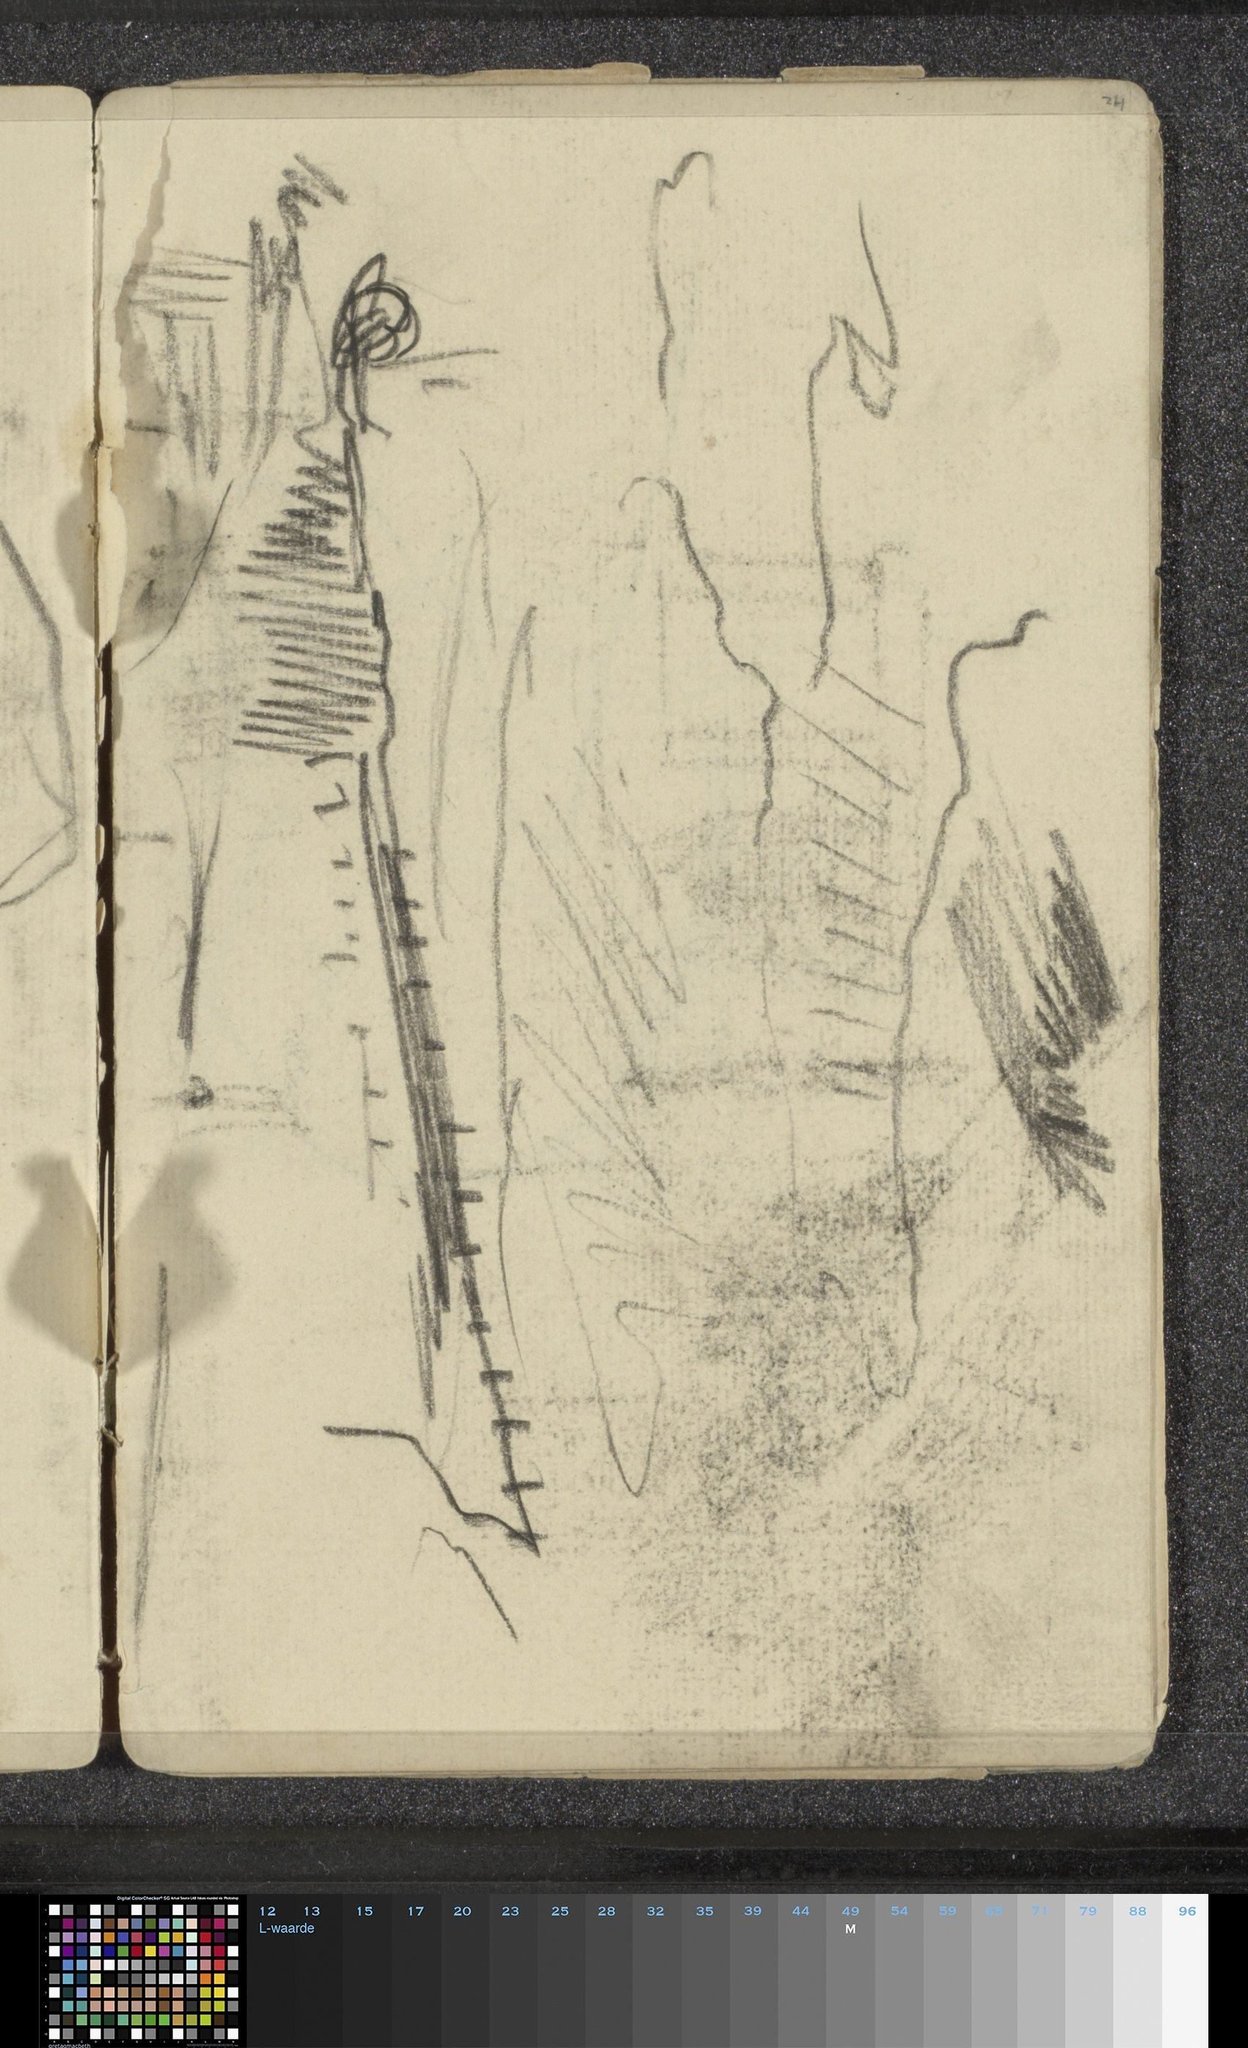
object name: sketchbook leaf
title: Studie, mogelijk van een boot in een landschap met wolkenlucht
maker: george hendrik breitner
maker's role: draughtsman, painter, print maker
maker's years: 1857-1923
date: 1880-1882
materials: chalk, paper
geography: the hague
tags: landscapes, clouds, ships (in general)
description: Pagina 24 uit een schetsboek met 19 bladen.